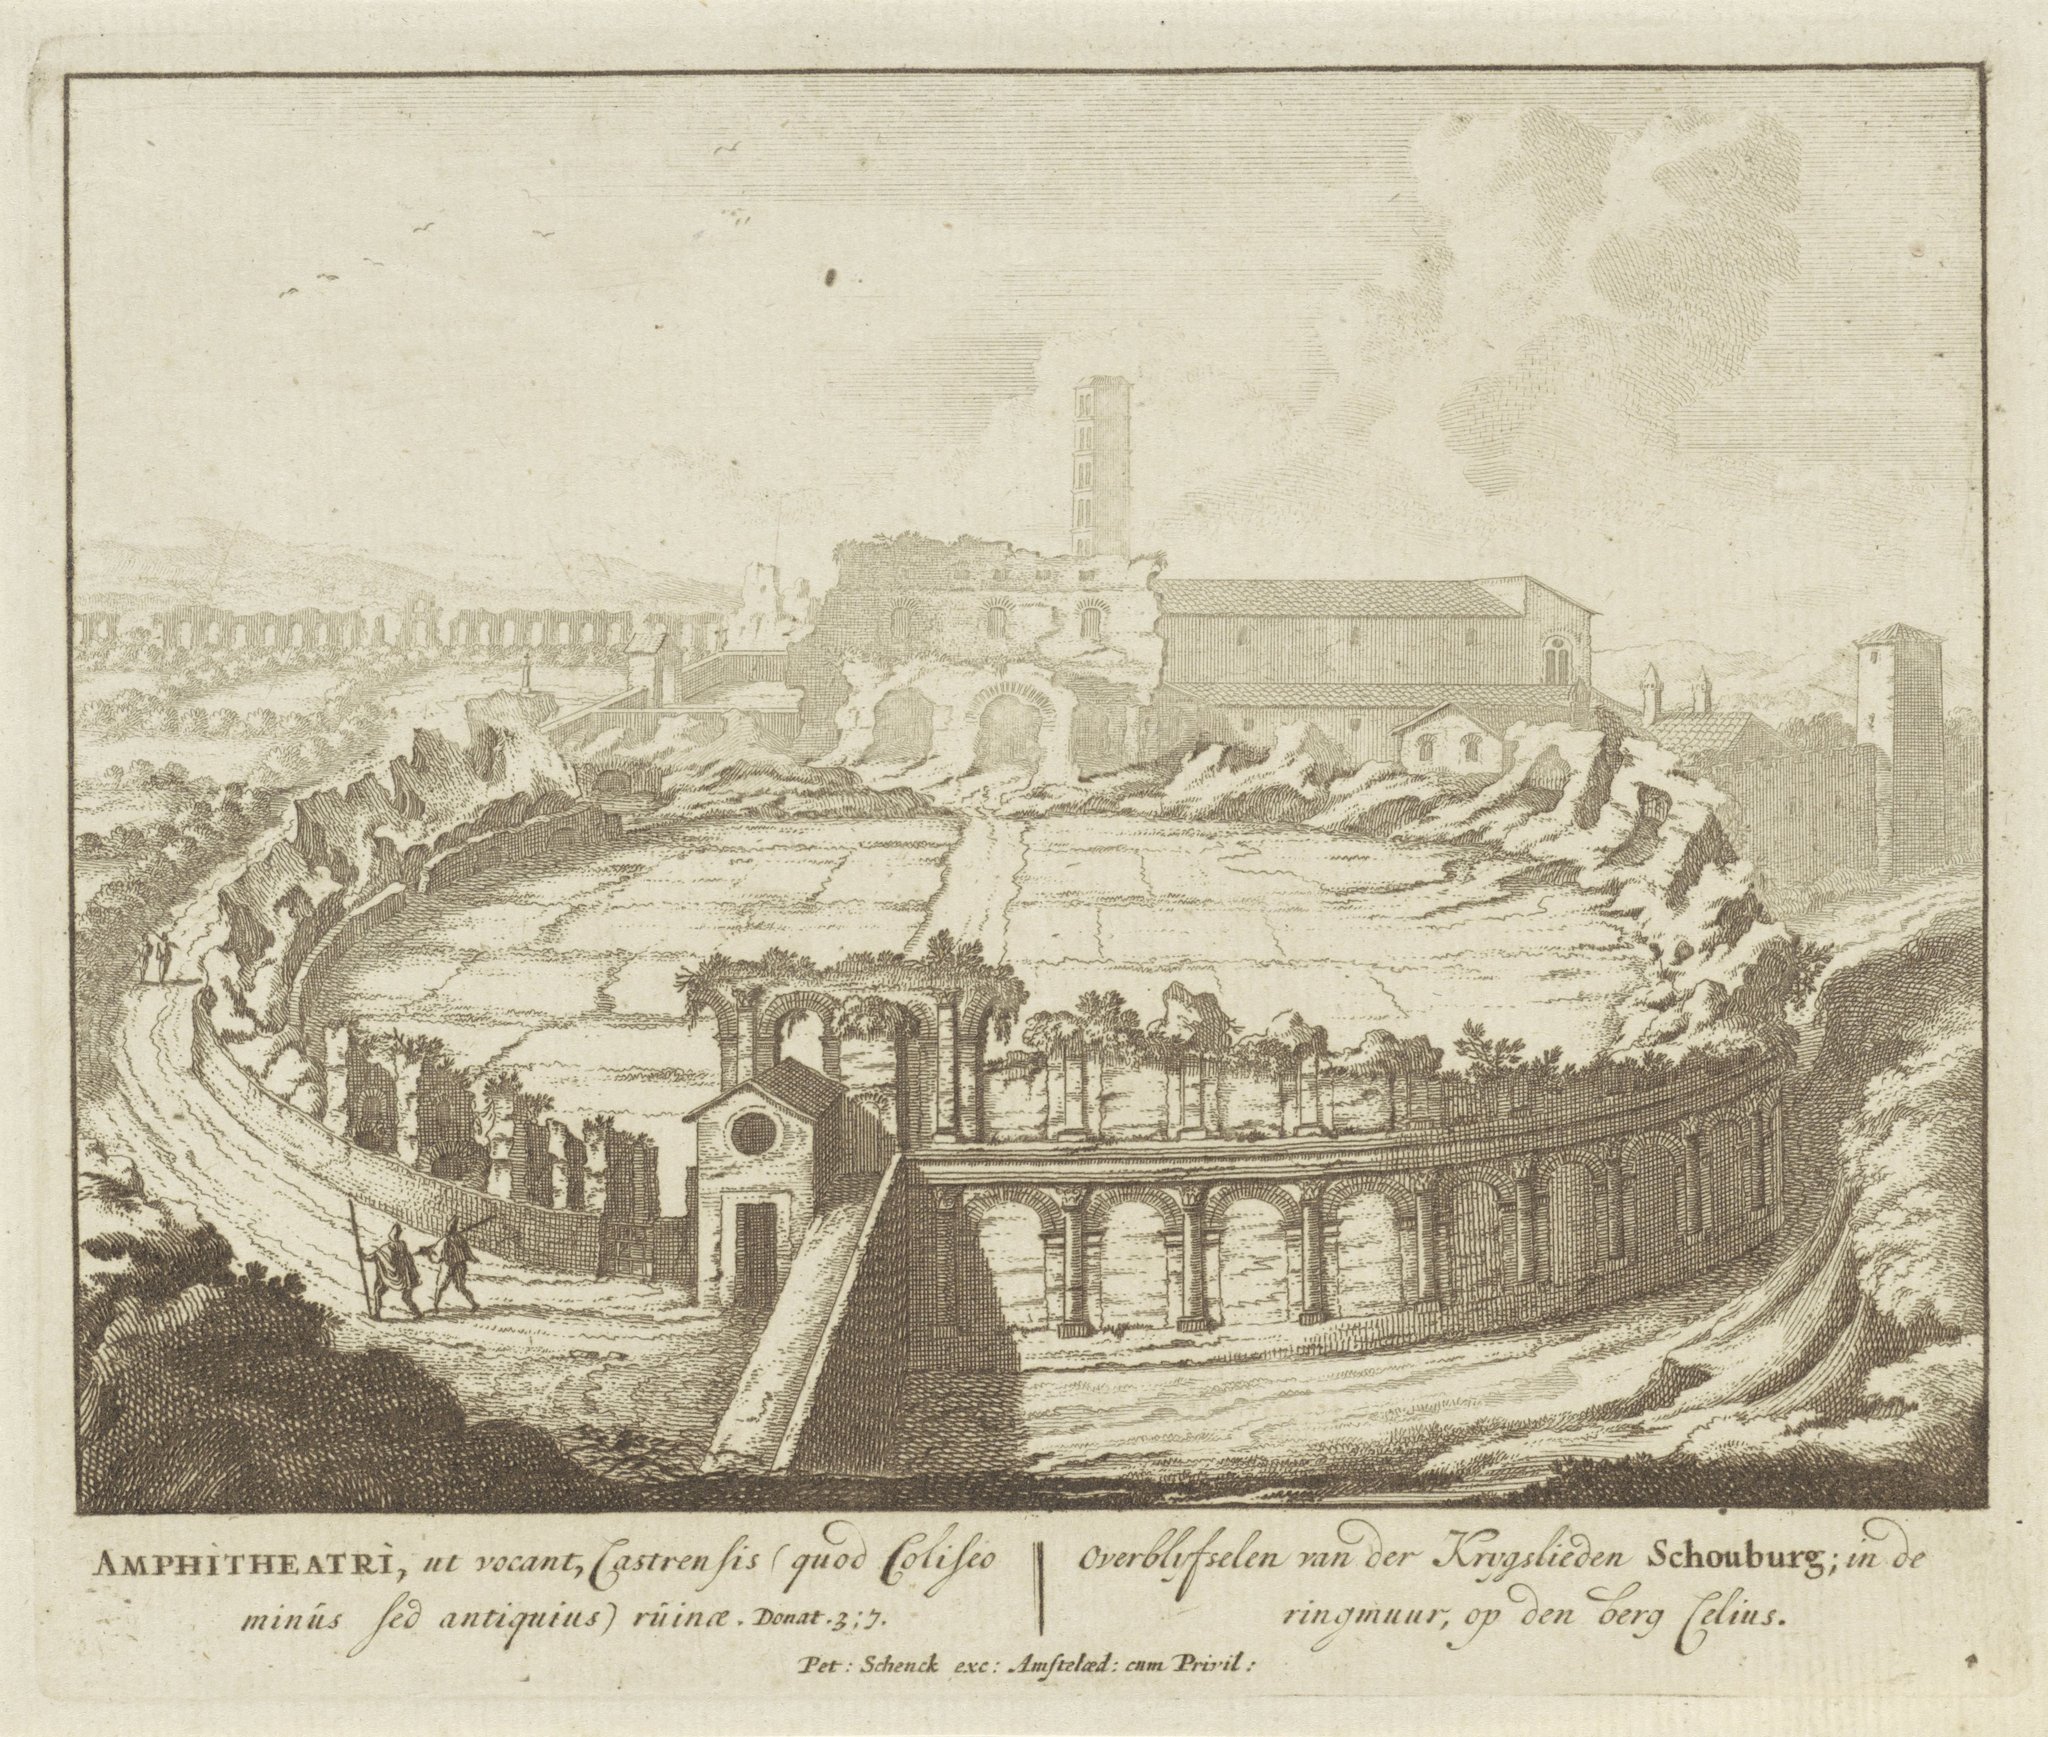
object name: print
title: Amphitheatrum Castrense te Rome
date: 1675-1711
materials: paper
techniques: etching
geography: amsterdam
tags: ruin of a building ~ architecture, theatre (building), rome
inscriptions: collector's mark: Lugt 2228